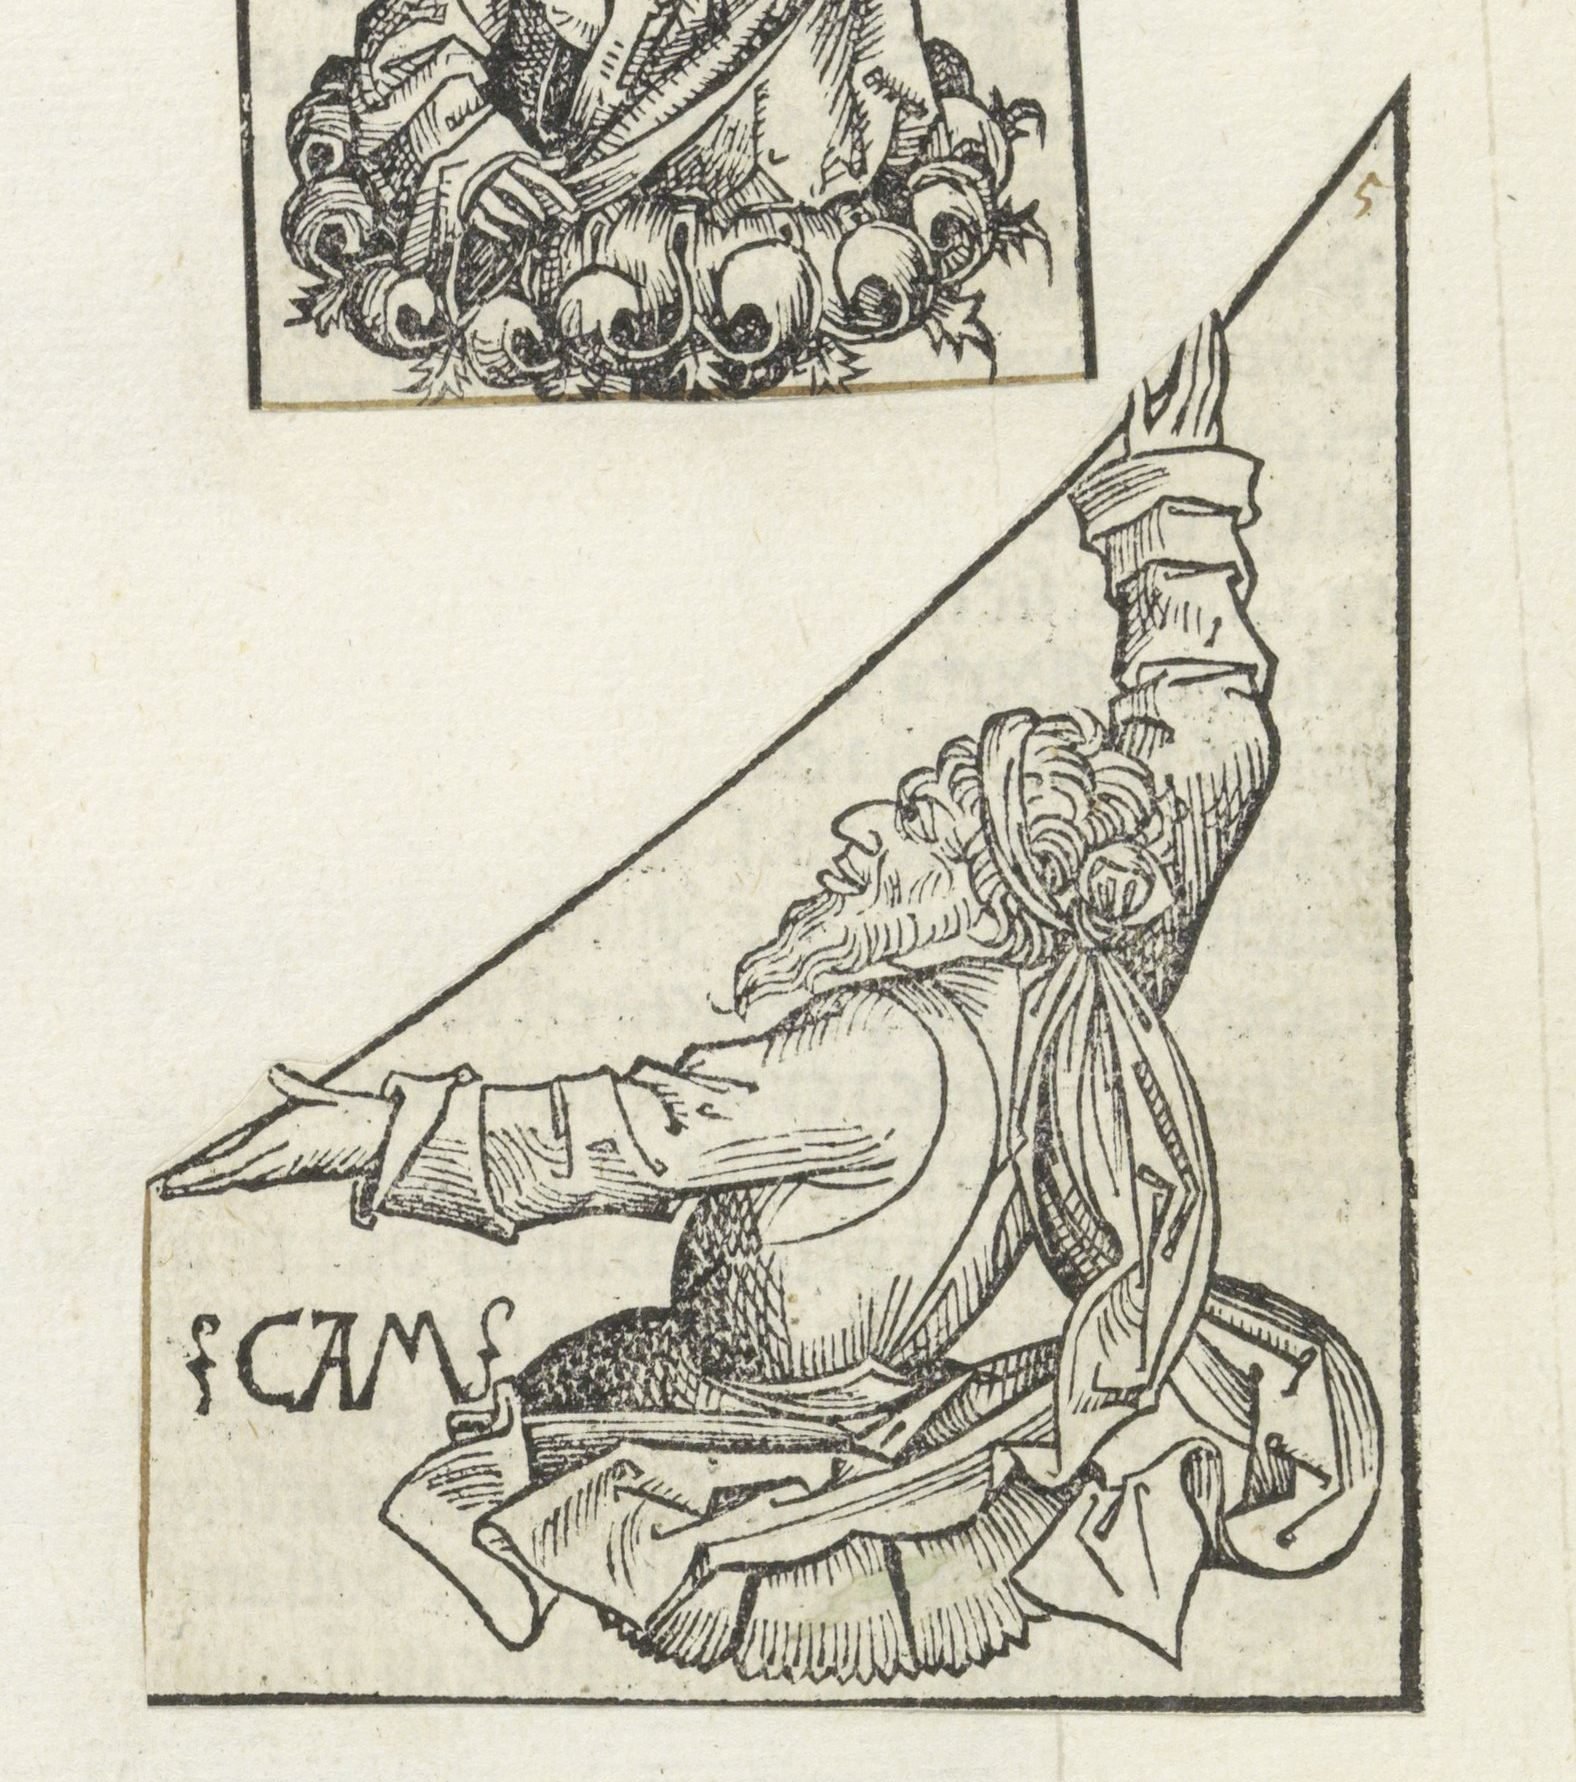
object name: album leaf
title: Liber Chronicarum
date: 1493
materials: paper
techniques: letterpress printing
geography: nuremberg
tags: persons from the old testament (not in biblical context, nor occurring in legendary/historical extensions included in division 71)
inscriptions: inscription: ‘5’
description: Een bebaarde man met een doek om zijn hoofd geknoopt, zijn armen gespreid. Het betreft een fragment van de wereldkaart in de Liber Chronicarum. De tekst identificeert hem als Cham, een zoon van Noach. De prent maakt deel uit van een album.